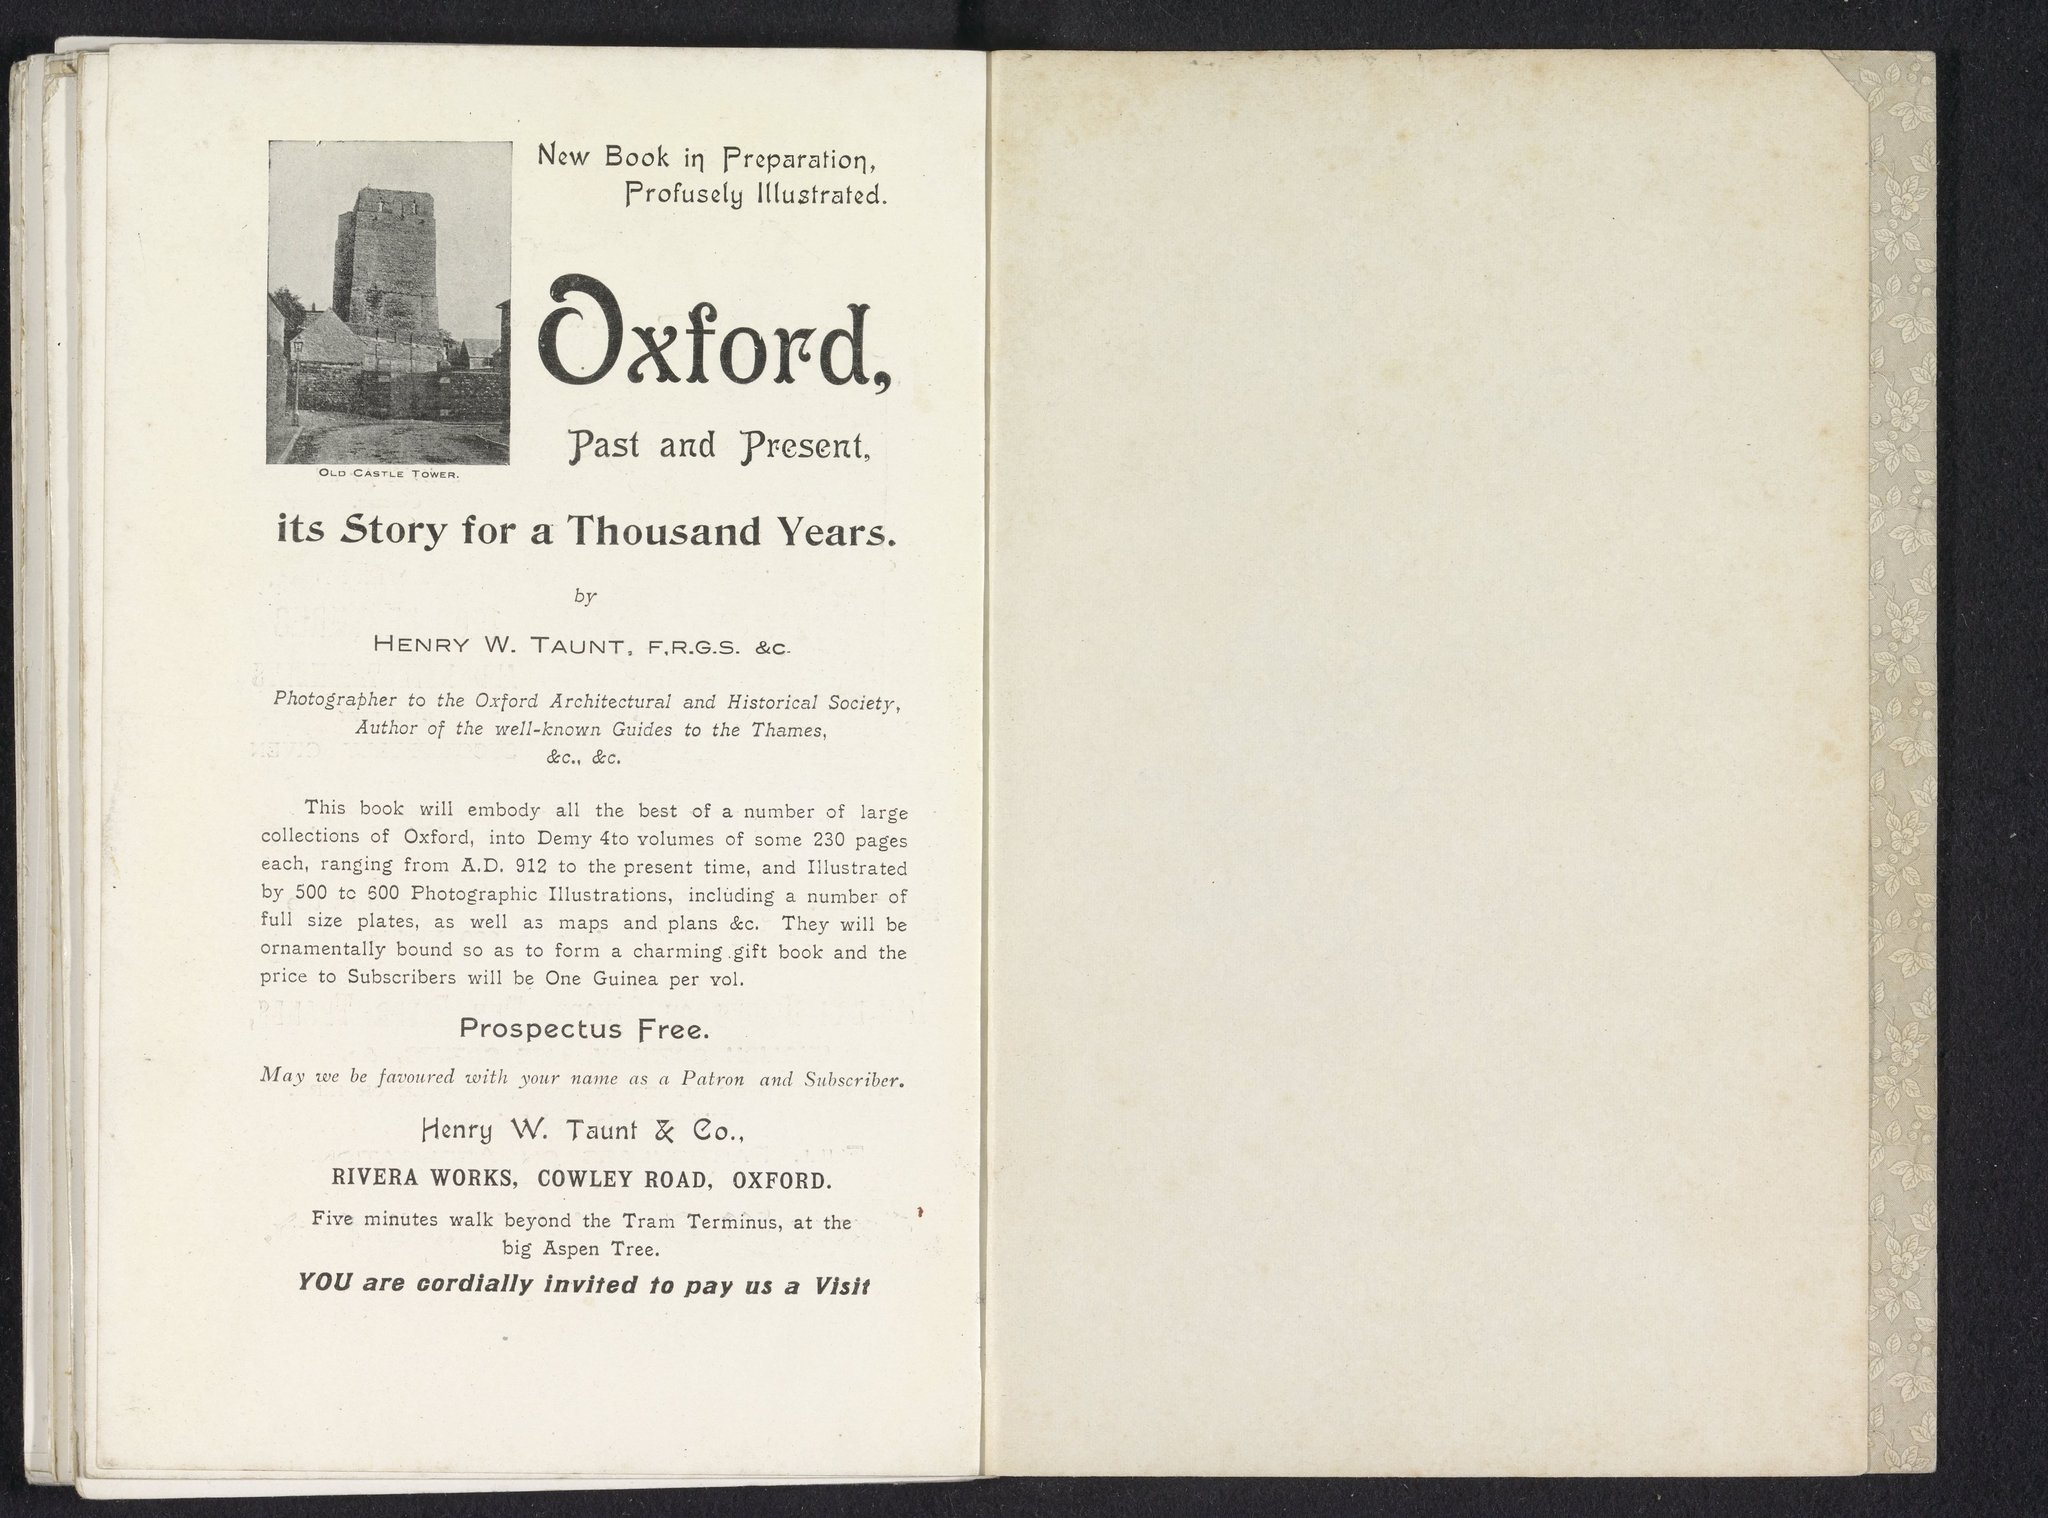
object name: photomechanical print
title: Old castle tower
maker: henry w. taunt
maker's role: fotograaf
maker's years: 1842-1922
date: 1907-1912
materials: paper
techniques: autotype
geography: oxford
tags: castle, towers ~ fortified city, façade (of house or building)